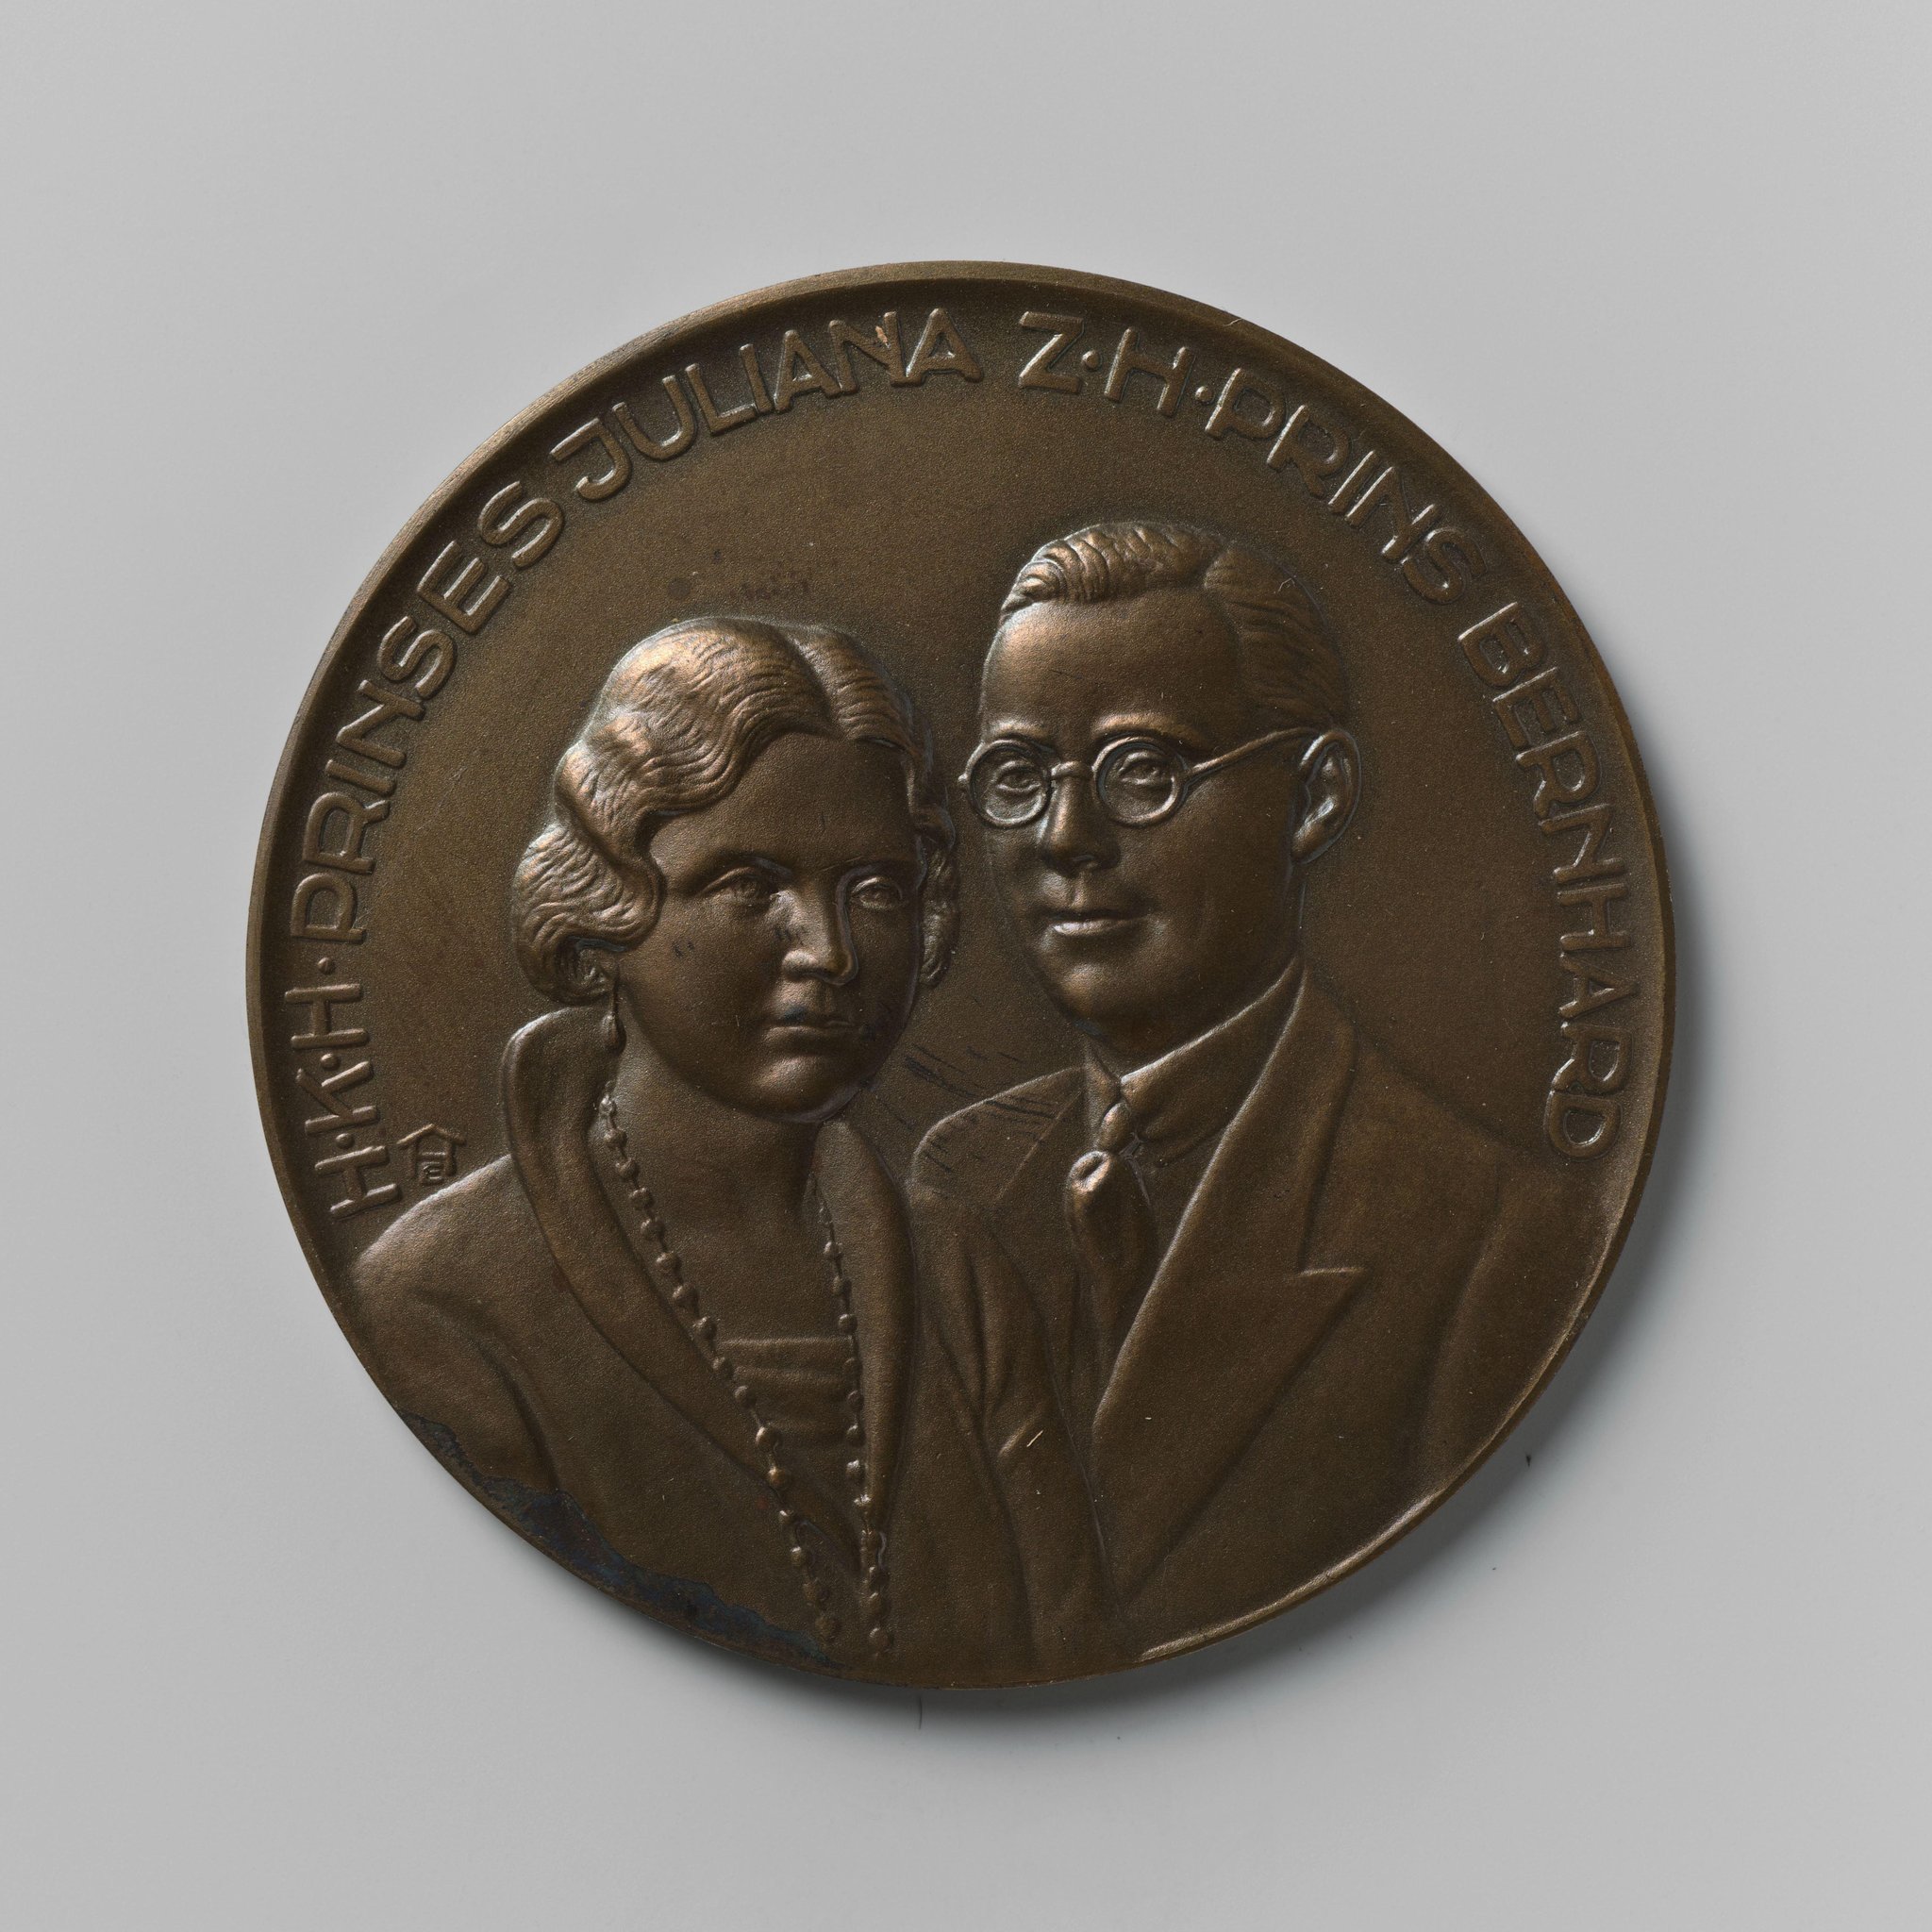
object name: history medal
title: Verloving van Prinses Juliana met Bernhard 1936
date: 1936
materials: bronze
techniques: striking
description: Bronzen penning, op de voorzijde de elkaar half toegewende borstbeelden van Juliana en Bernhard met bovenaan omschrift, op de keerzijde twee wapenschilden tegen een oranjeboom met één regel tekst.